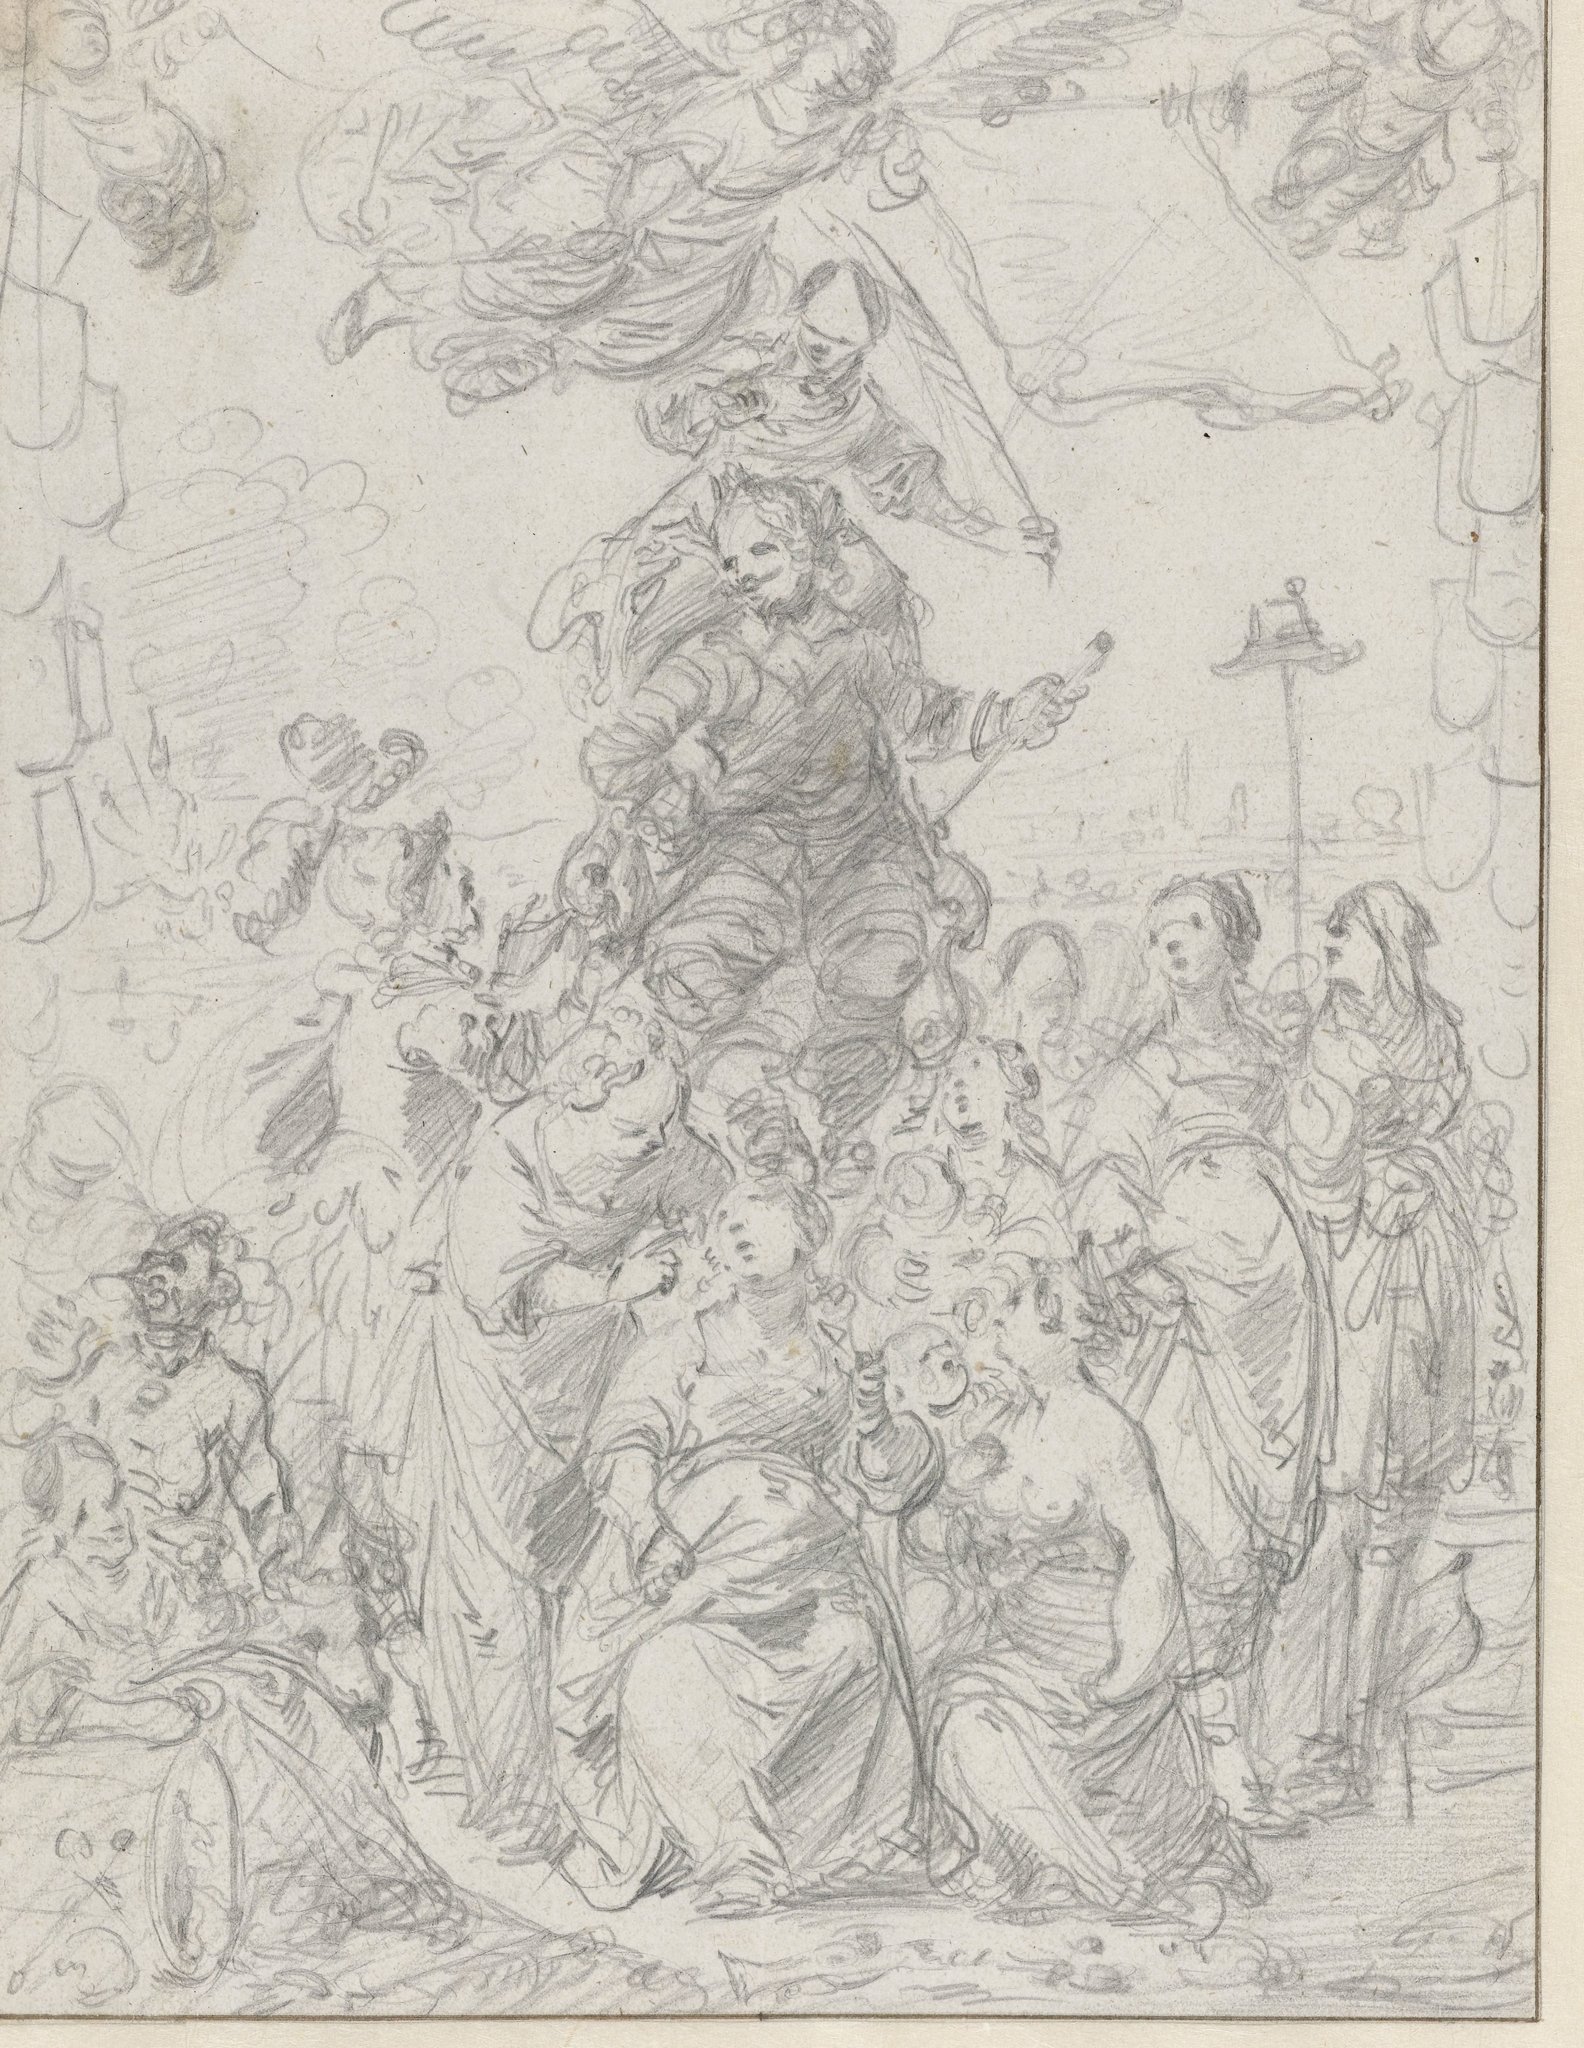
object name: drawing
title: Frontispiece Design Sketch for Frederick Hendrick van Nassauw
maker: pieter jansz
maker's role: draughtsman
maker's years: 1602-1672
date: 1651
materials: graphite, paper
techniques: pouncing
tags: delft, the hague, frederick henry (prince of orange), historical persons, symbolic triumphs of individual persons, triumph of mars; 'carro di marte' (ripa), 'historia'; 'historia' (ripa), fame; 'fama', 'fama buona', 'fama chiara' (ripa)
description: In many instances, the sketches for title page designs have not been preserved. The Rijksmuseum is thus fortunate to own two successive drawings of the Triumph of Frederick Henry by Pieter Jansz, who was also active as a stained glass painter. They differ little from one another. Drawing with pencil, as used for this design sketch, allowed the artist to rub out mistakes and make changes: this was much more difficult to do with ink.